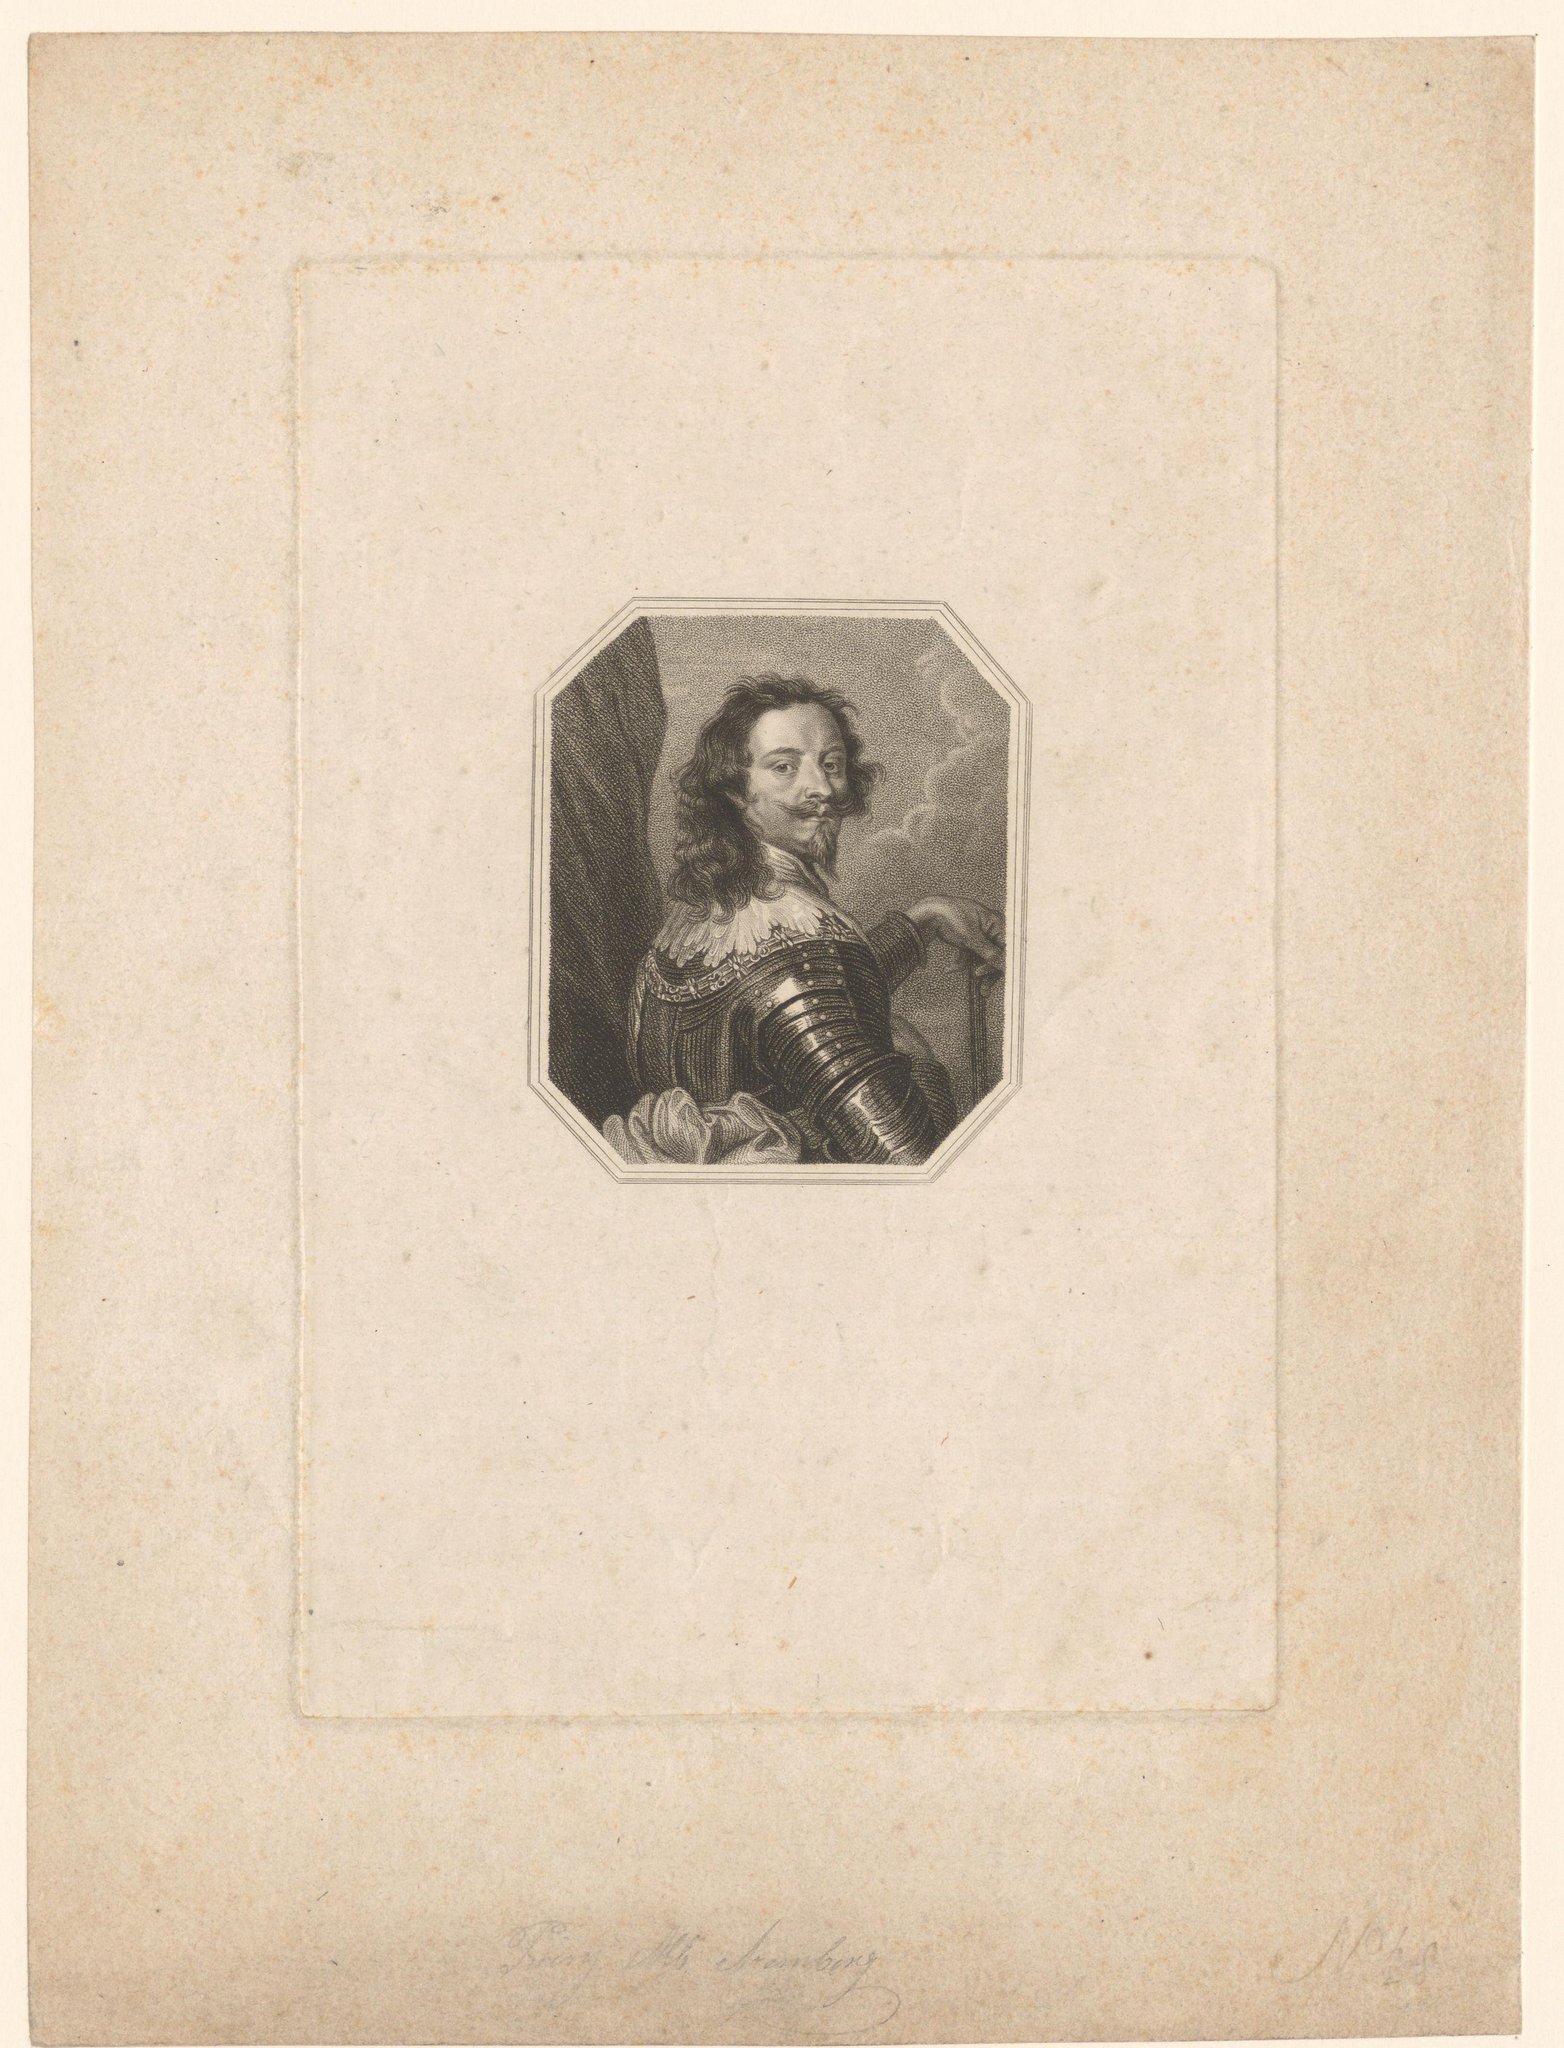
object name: print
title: Portret van Albert de Ligne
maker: edward scriven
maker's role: print maker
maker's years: 1775-1841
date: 1808-1810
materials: paper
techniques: etching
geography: london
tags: albert de ligne (prins van barbançon en arenberg), historical persons, officer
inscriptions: collector's mark: Lugt 2228